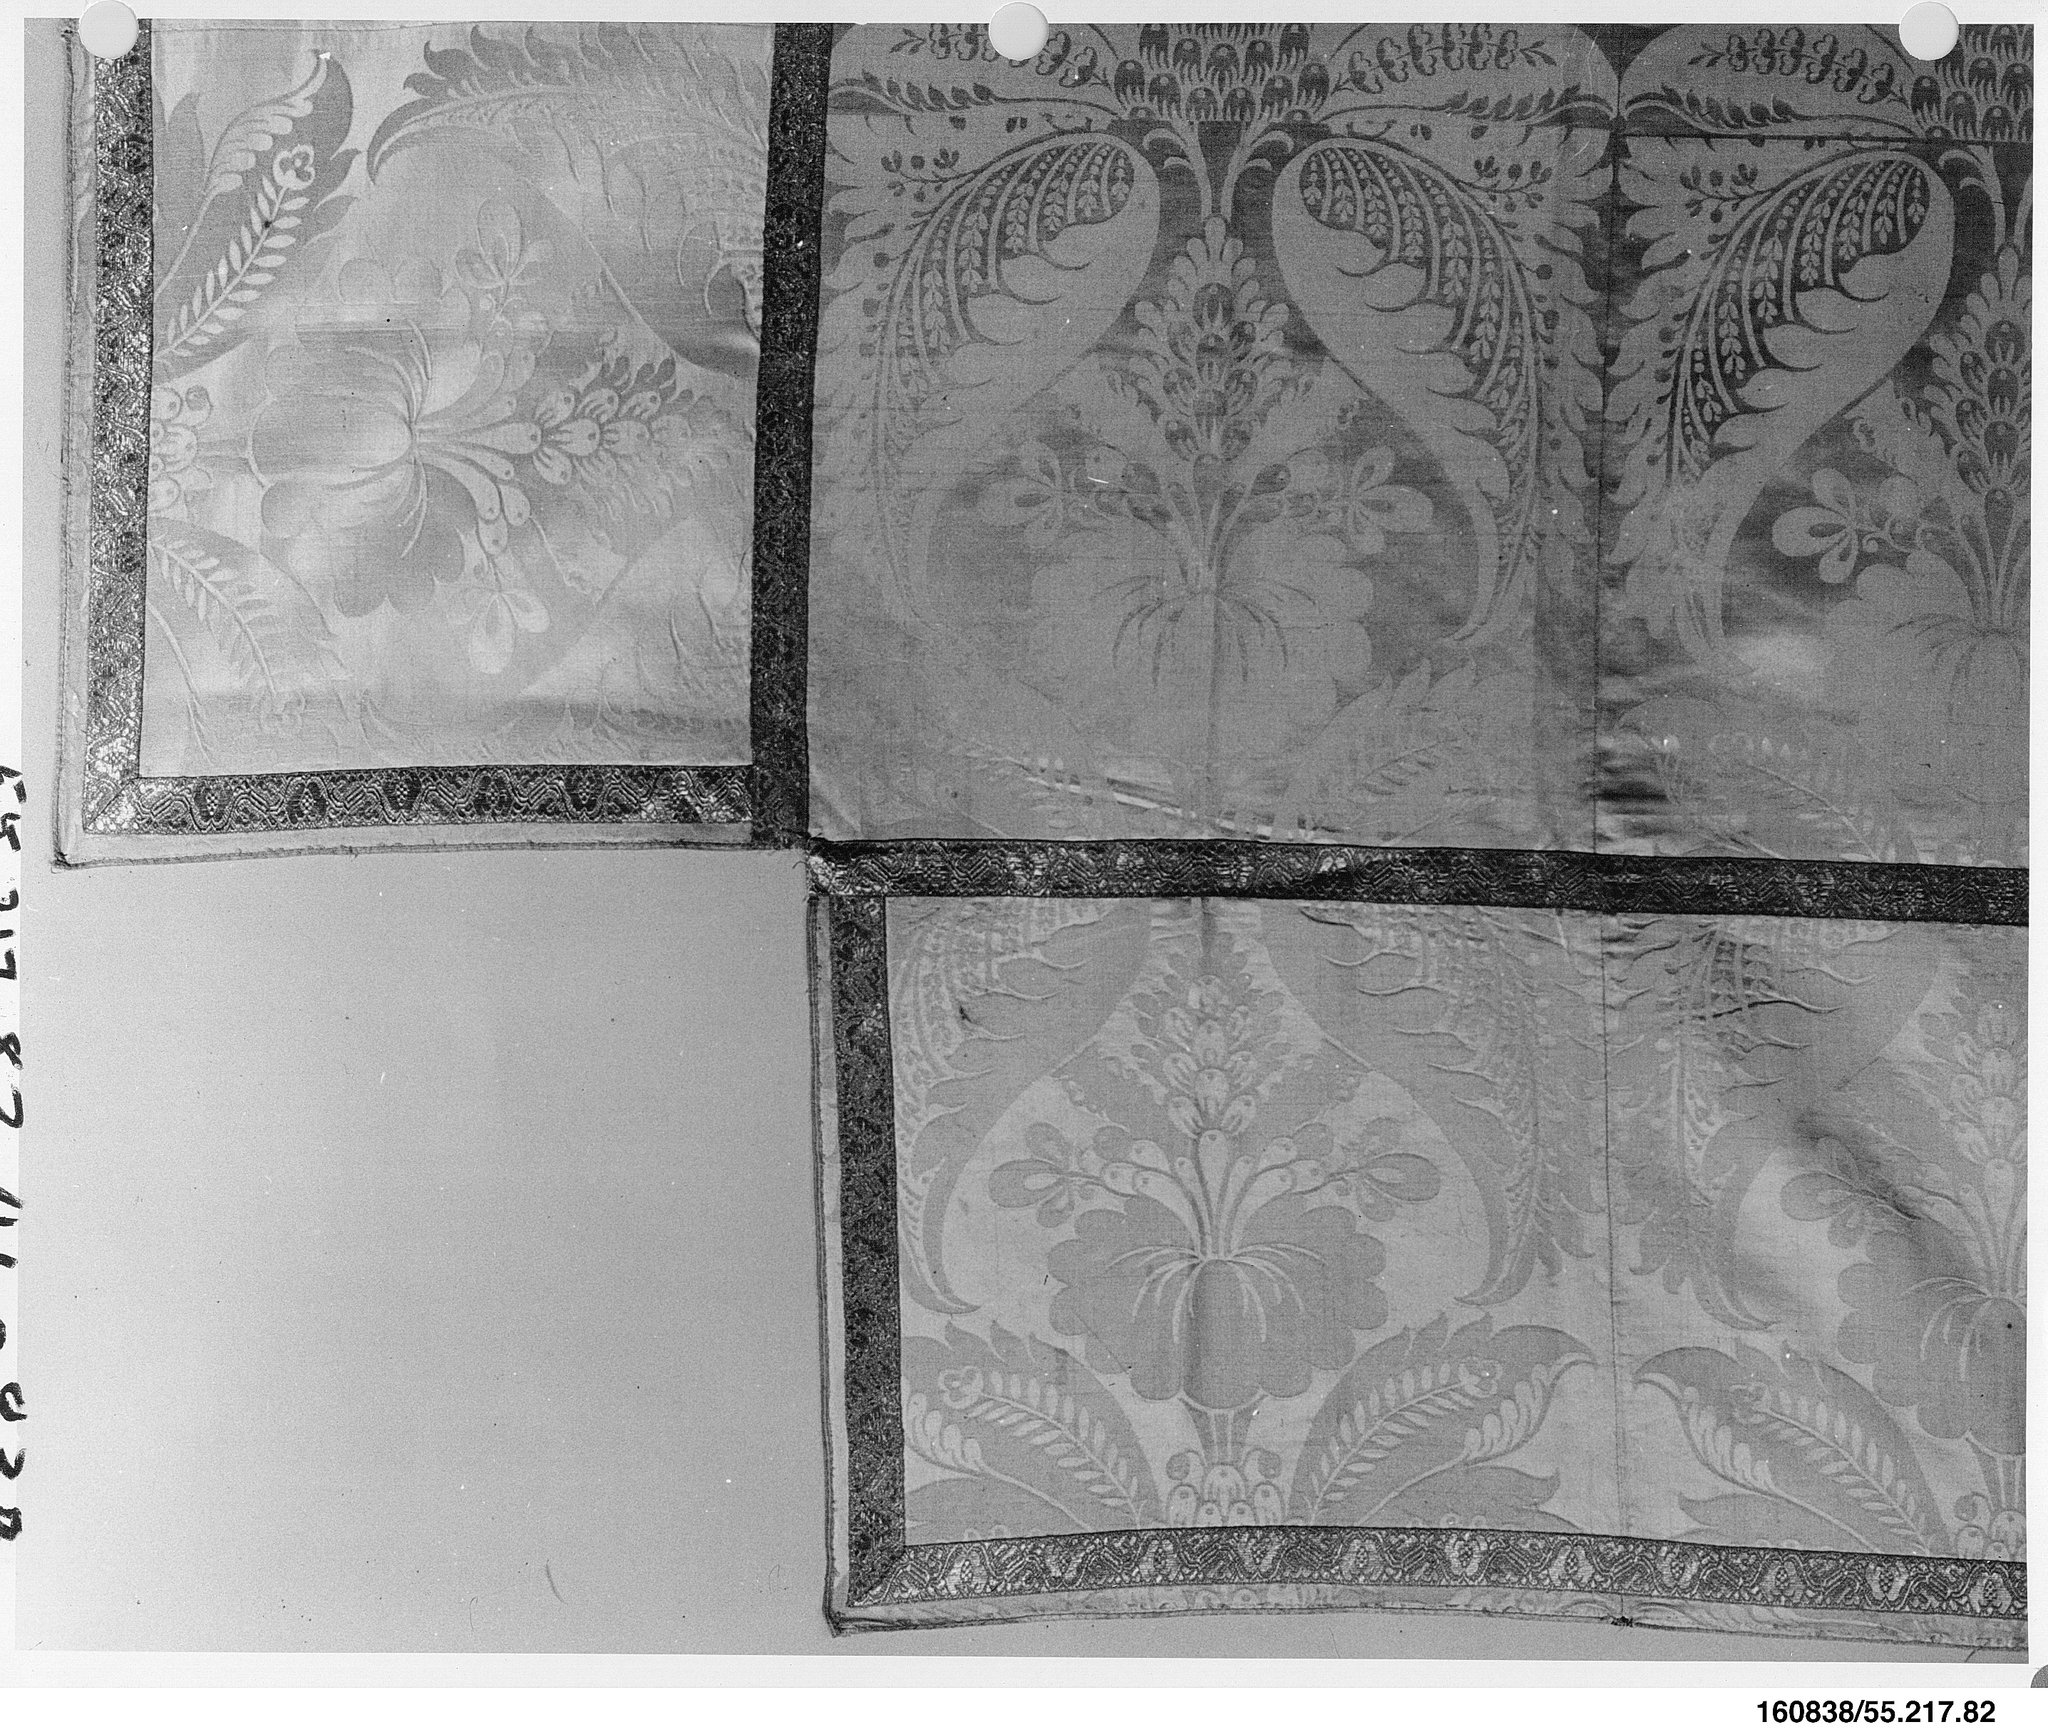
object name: bed cover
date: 1730-1760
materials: silk